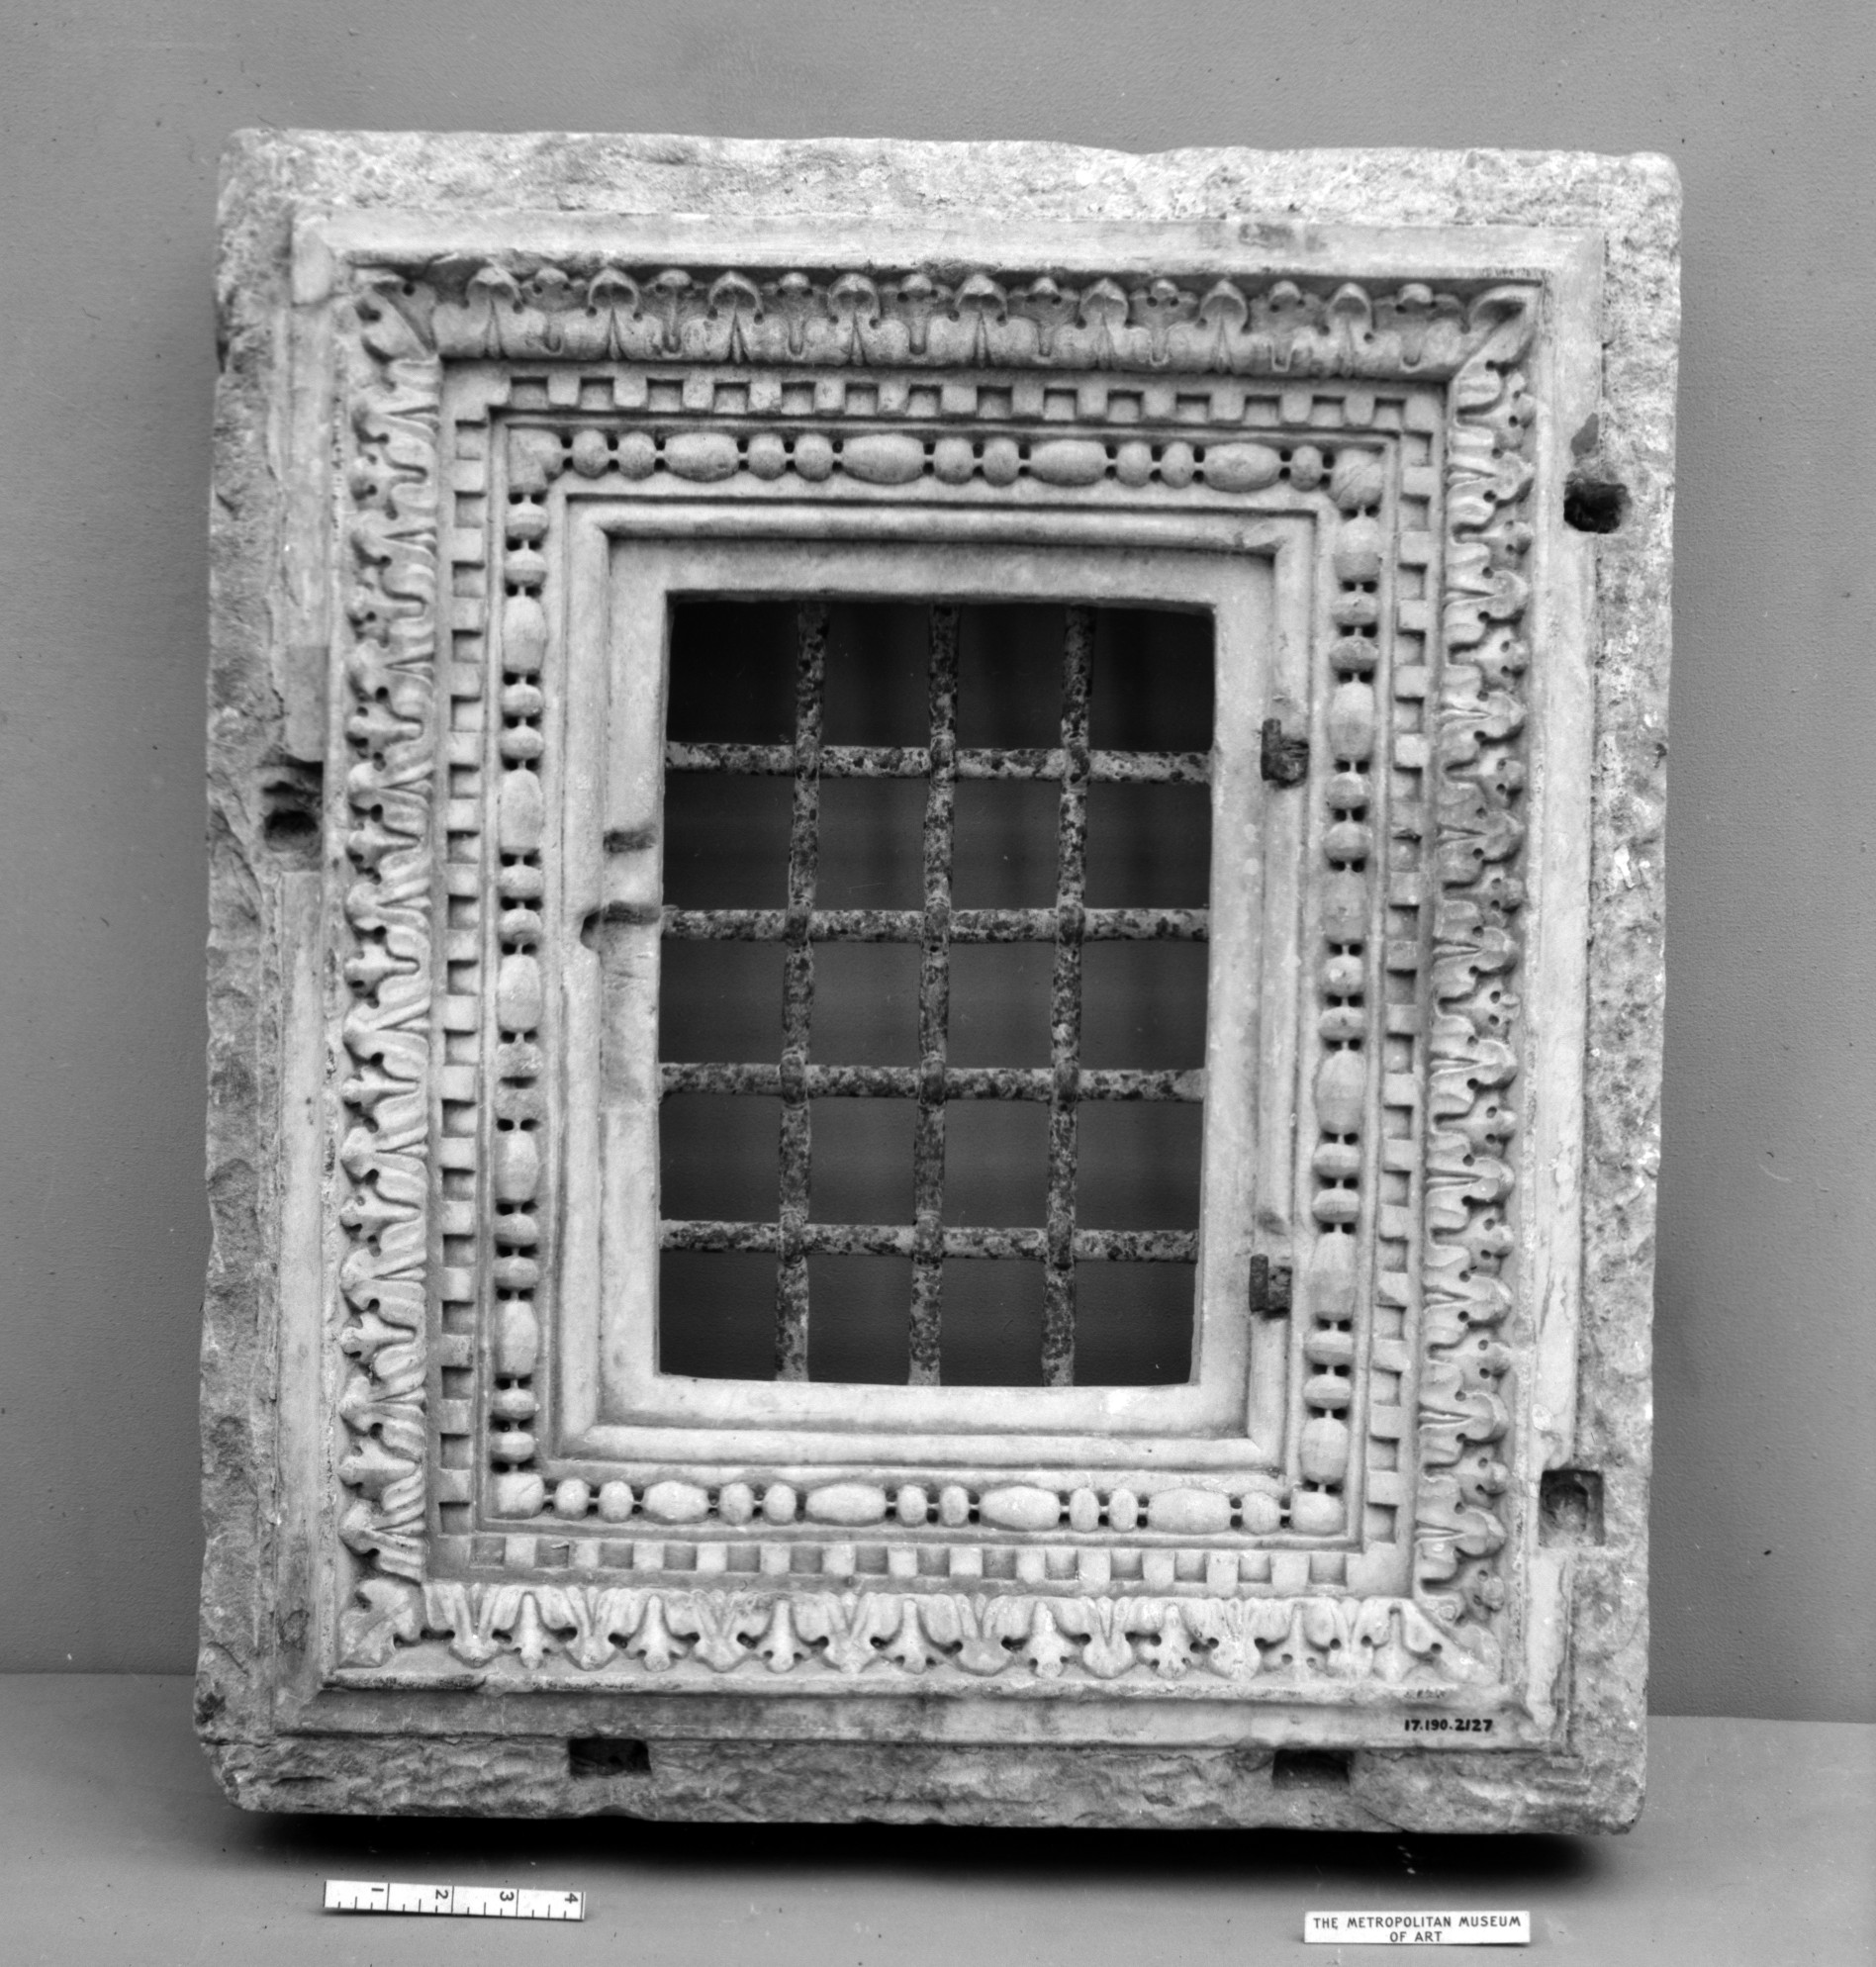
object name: window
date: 1401-1500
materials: iron, marble